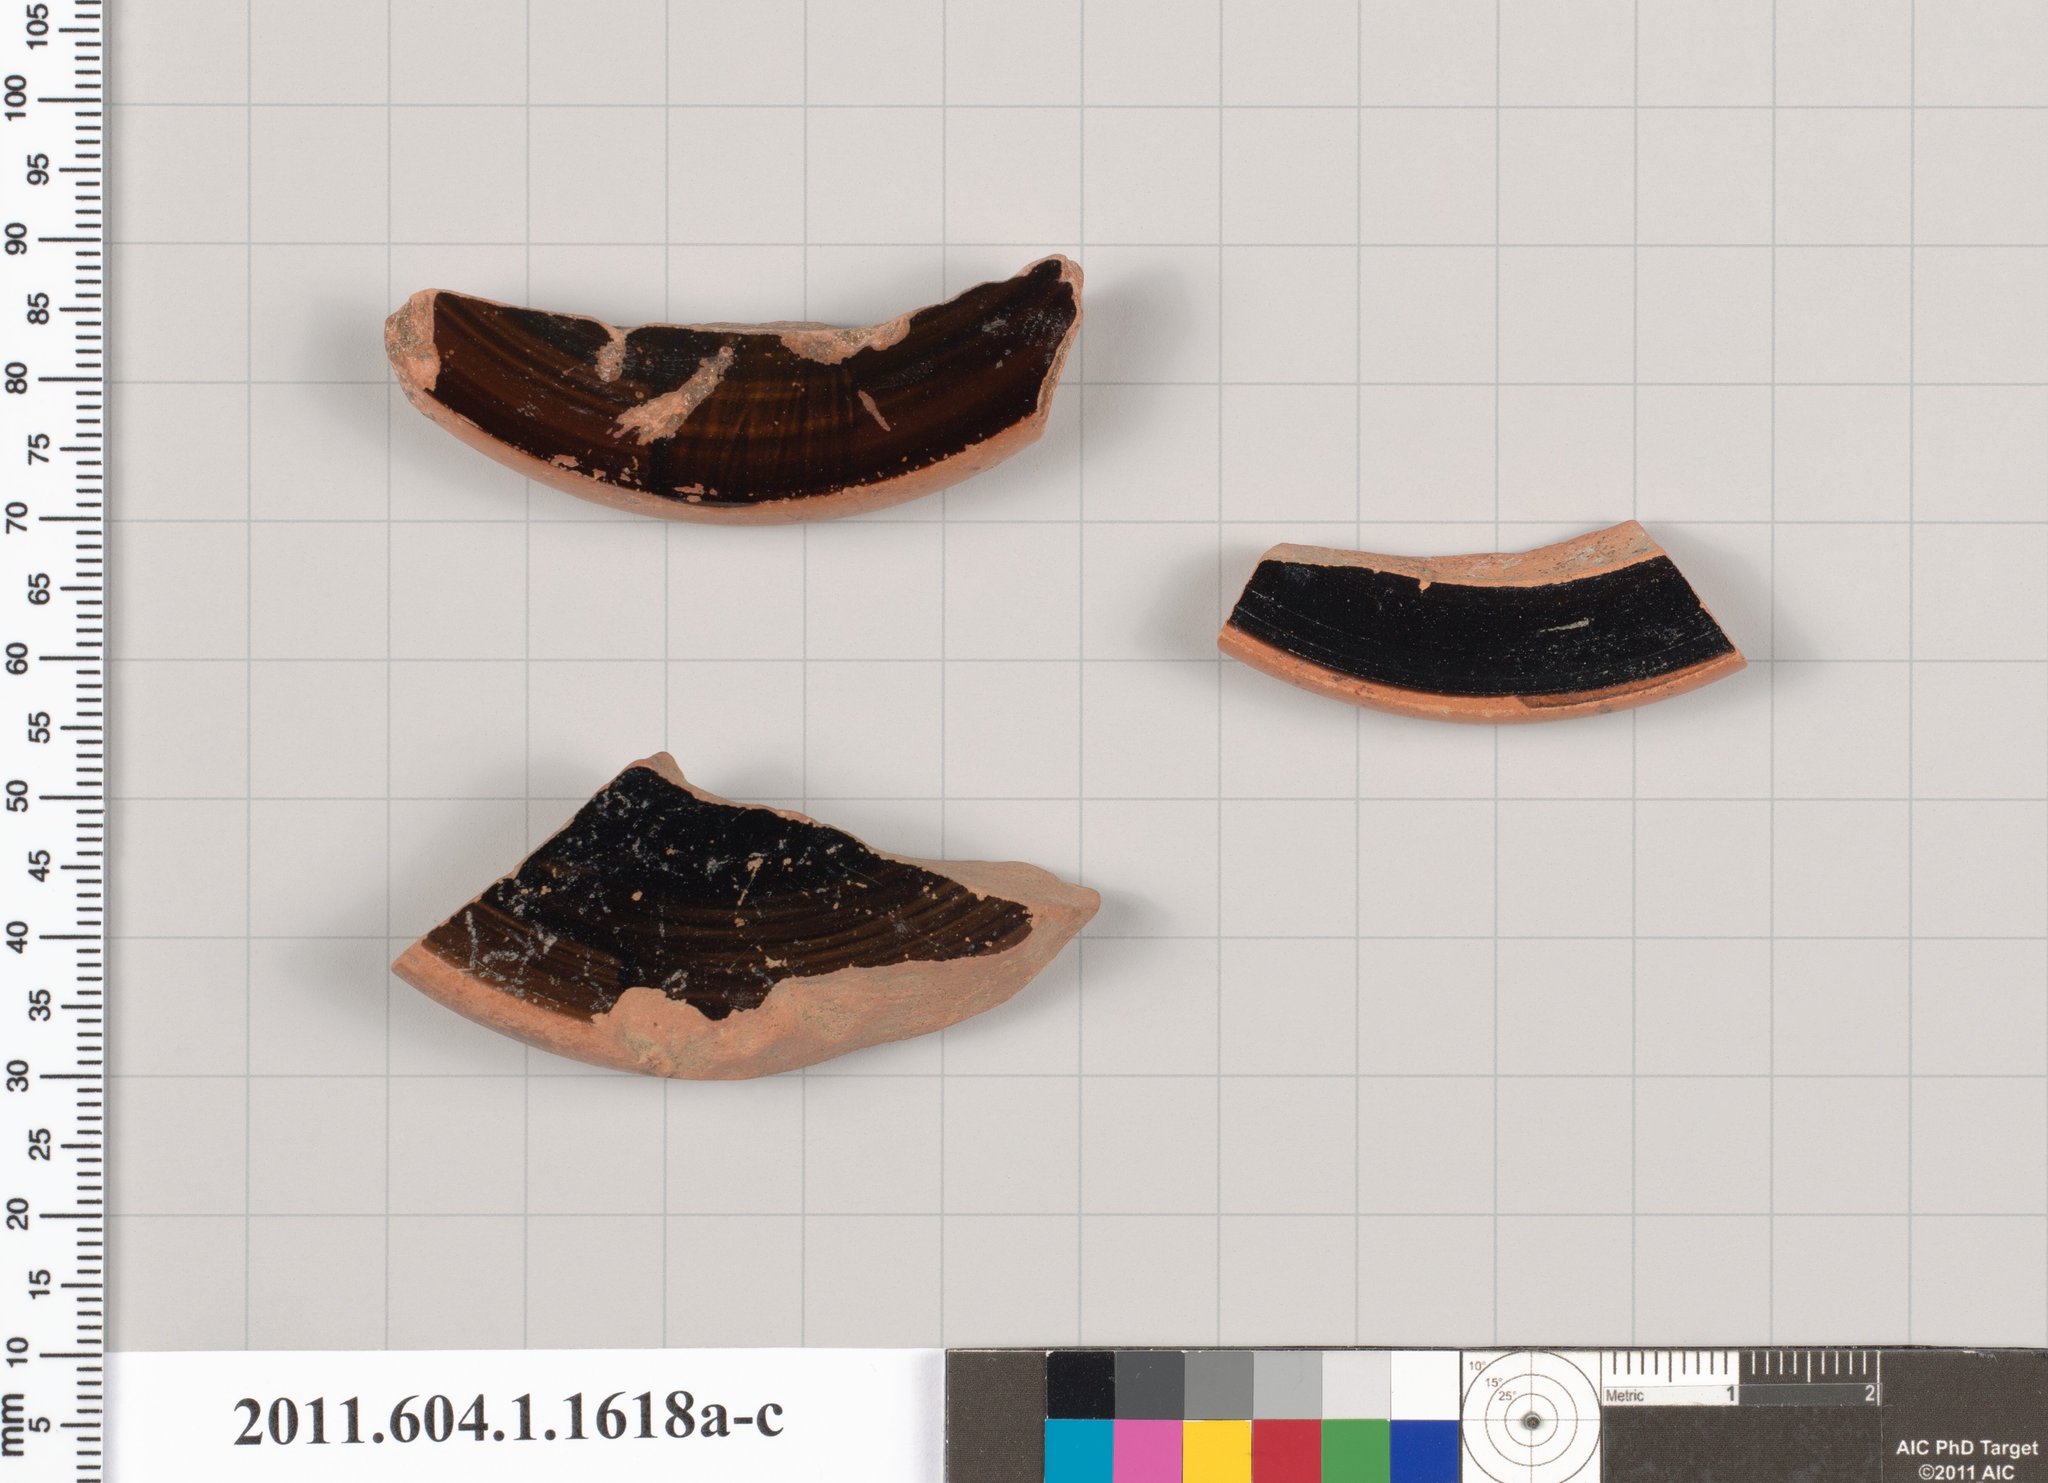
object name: kylix fragment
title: Terracotta fragments of kylikes (drinking cups)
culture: greek, attic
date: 500-401 BCE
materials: terracotta